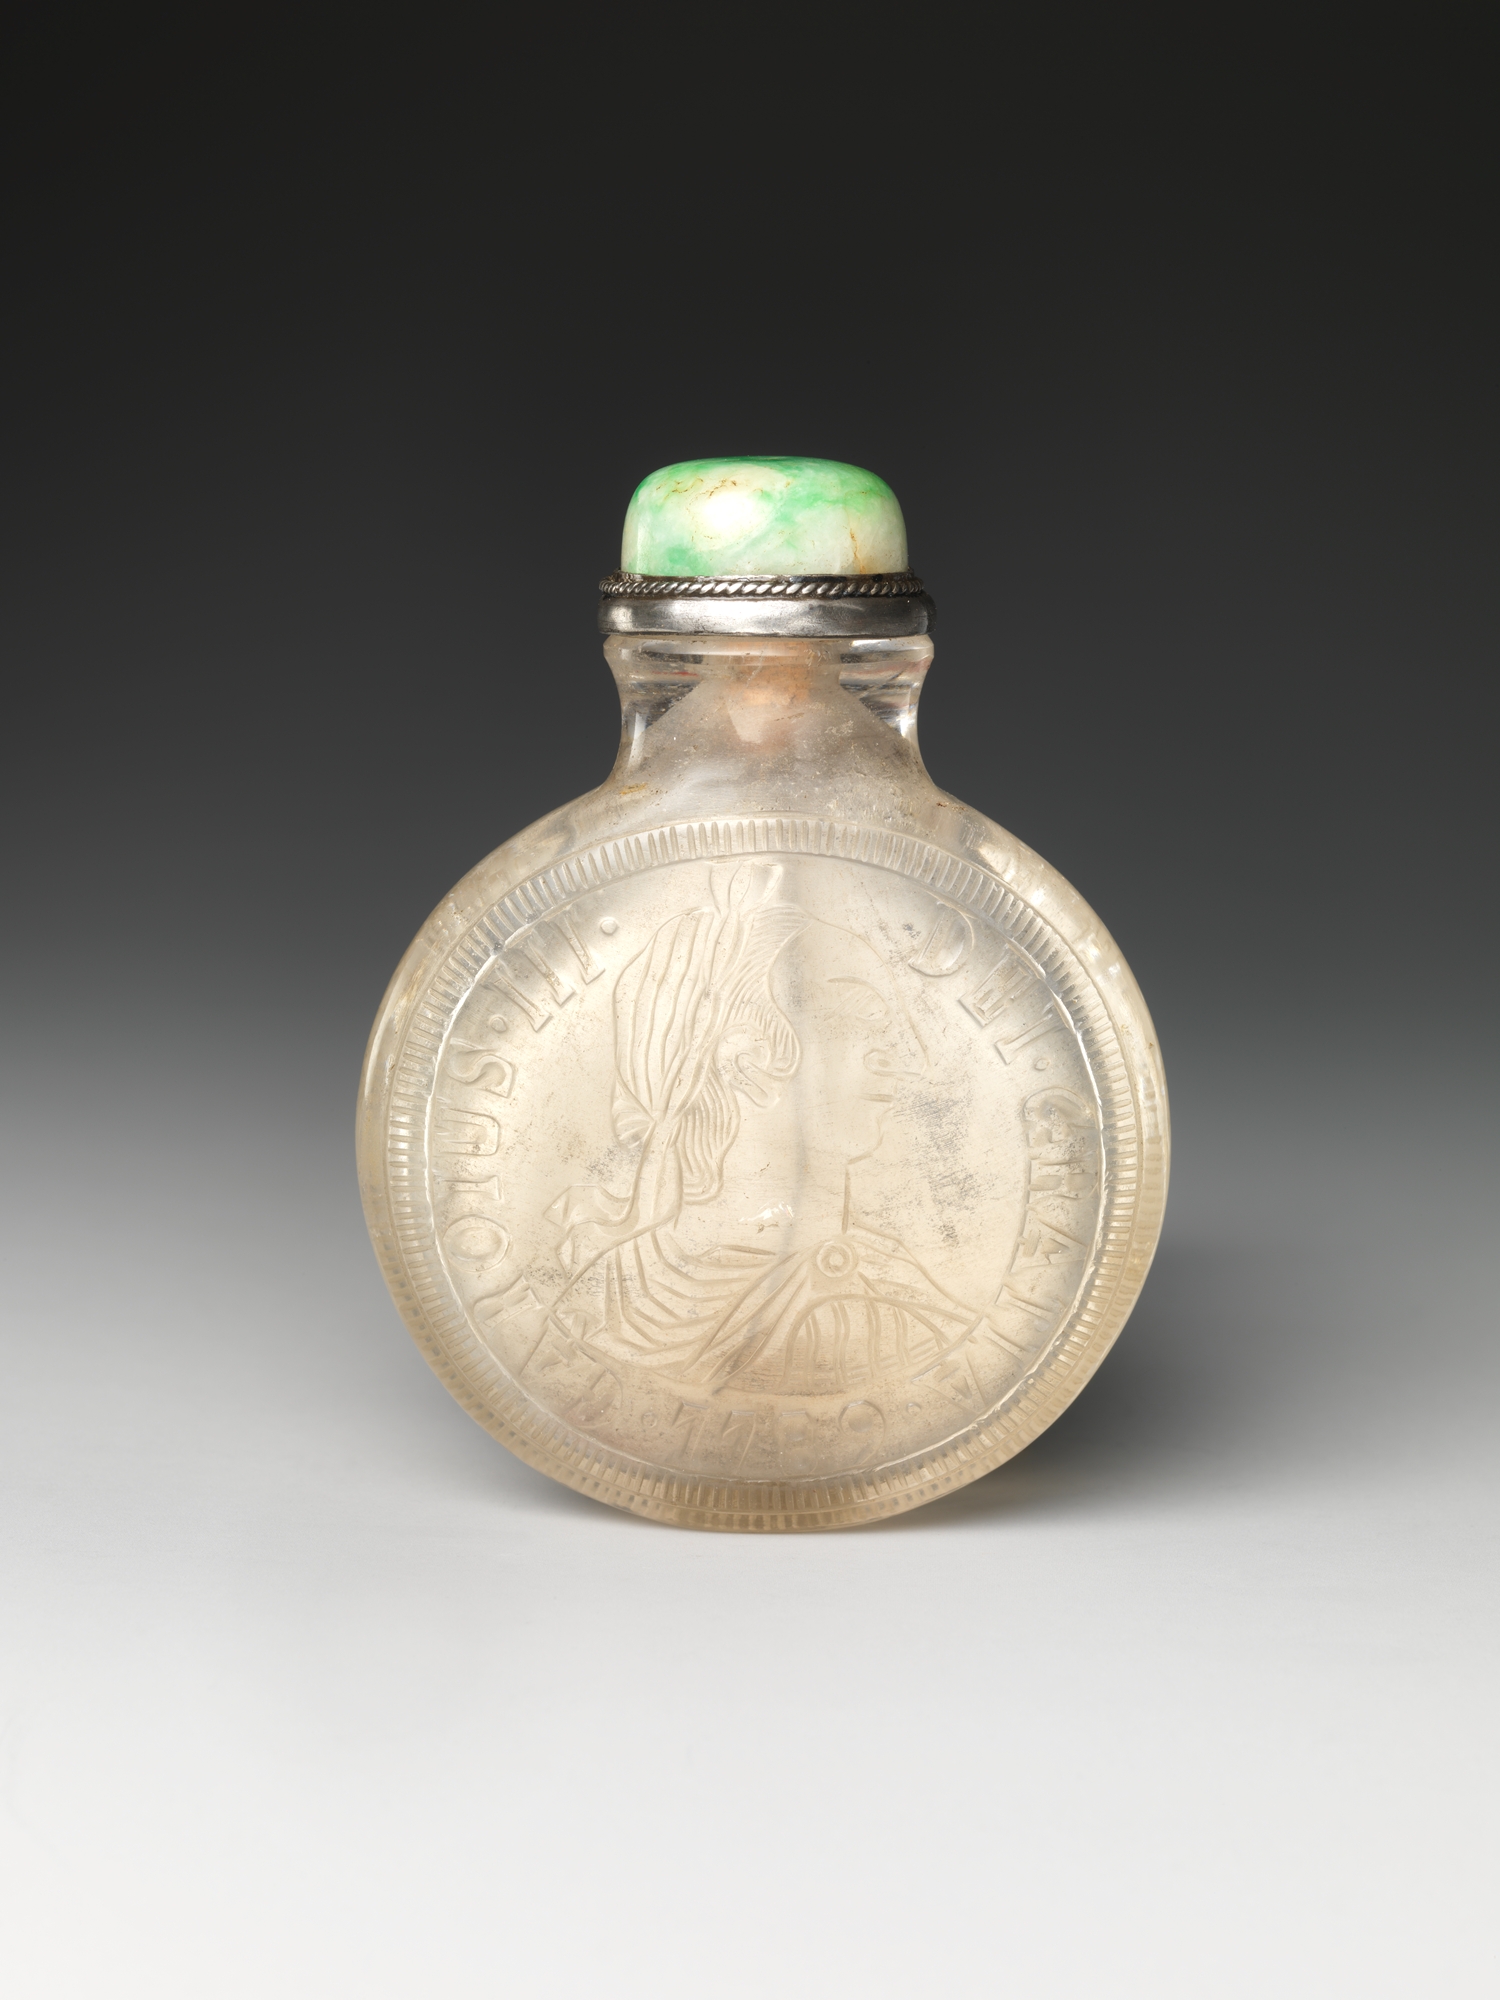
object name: snuff bottle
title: Snuff bottle with Mexican eight reales coin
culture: chinese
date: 1767-1833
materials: jade, quartz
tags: coins